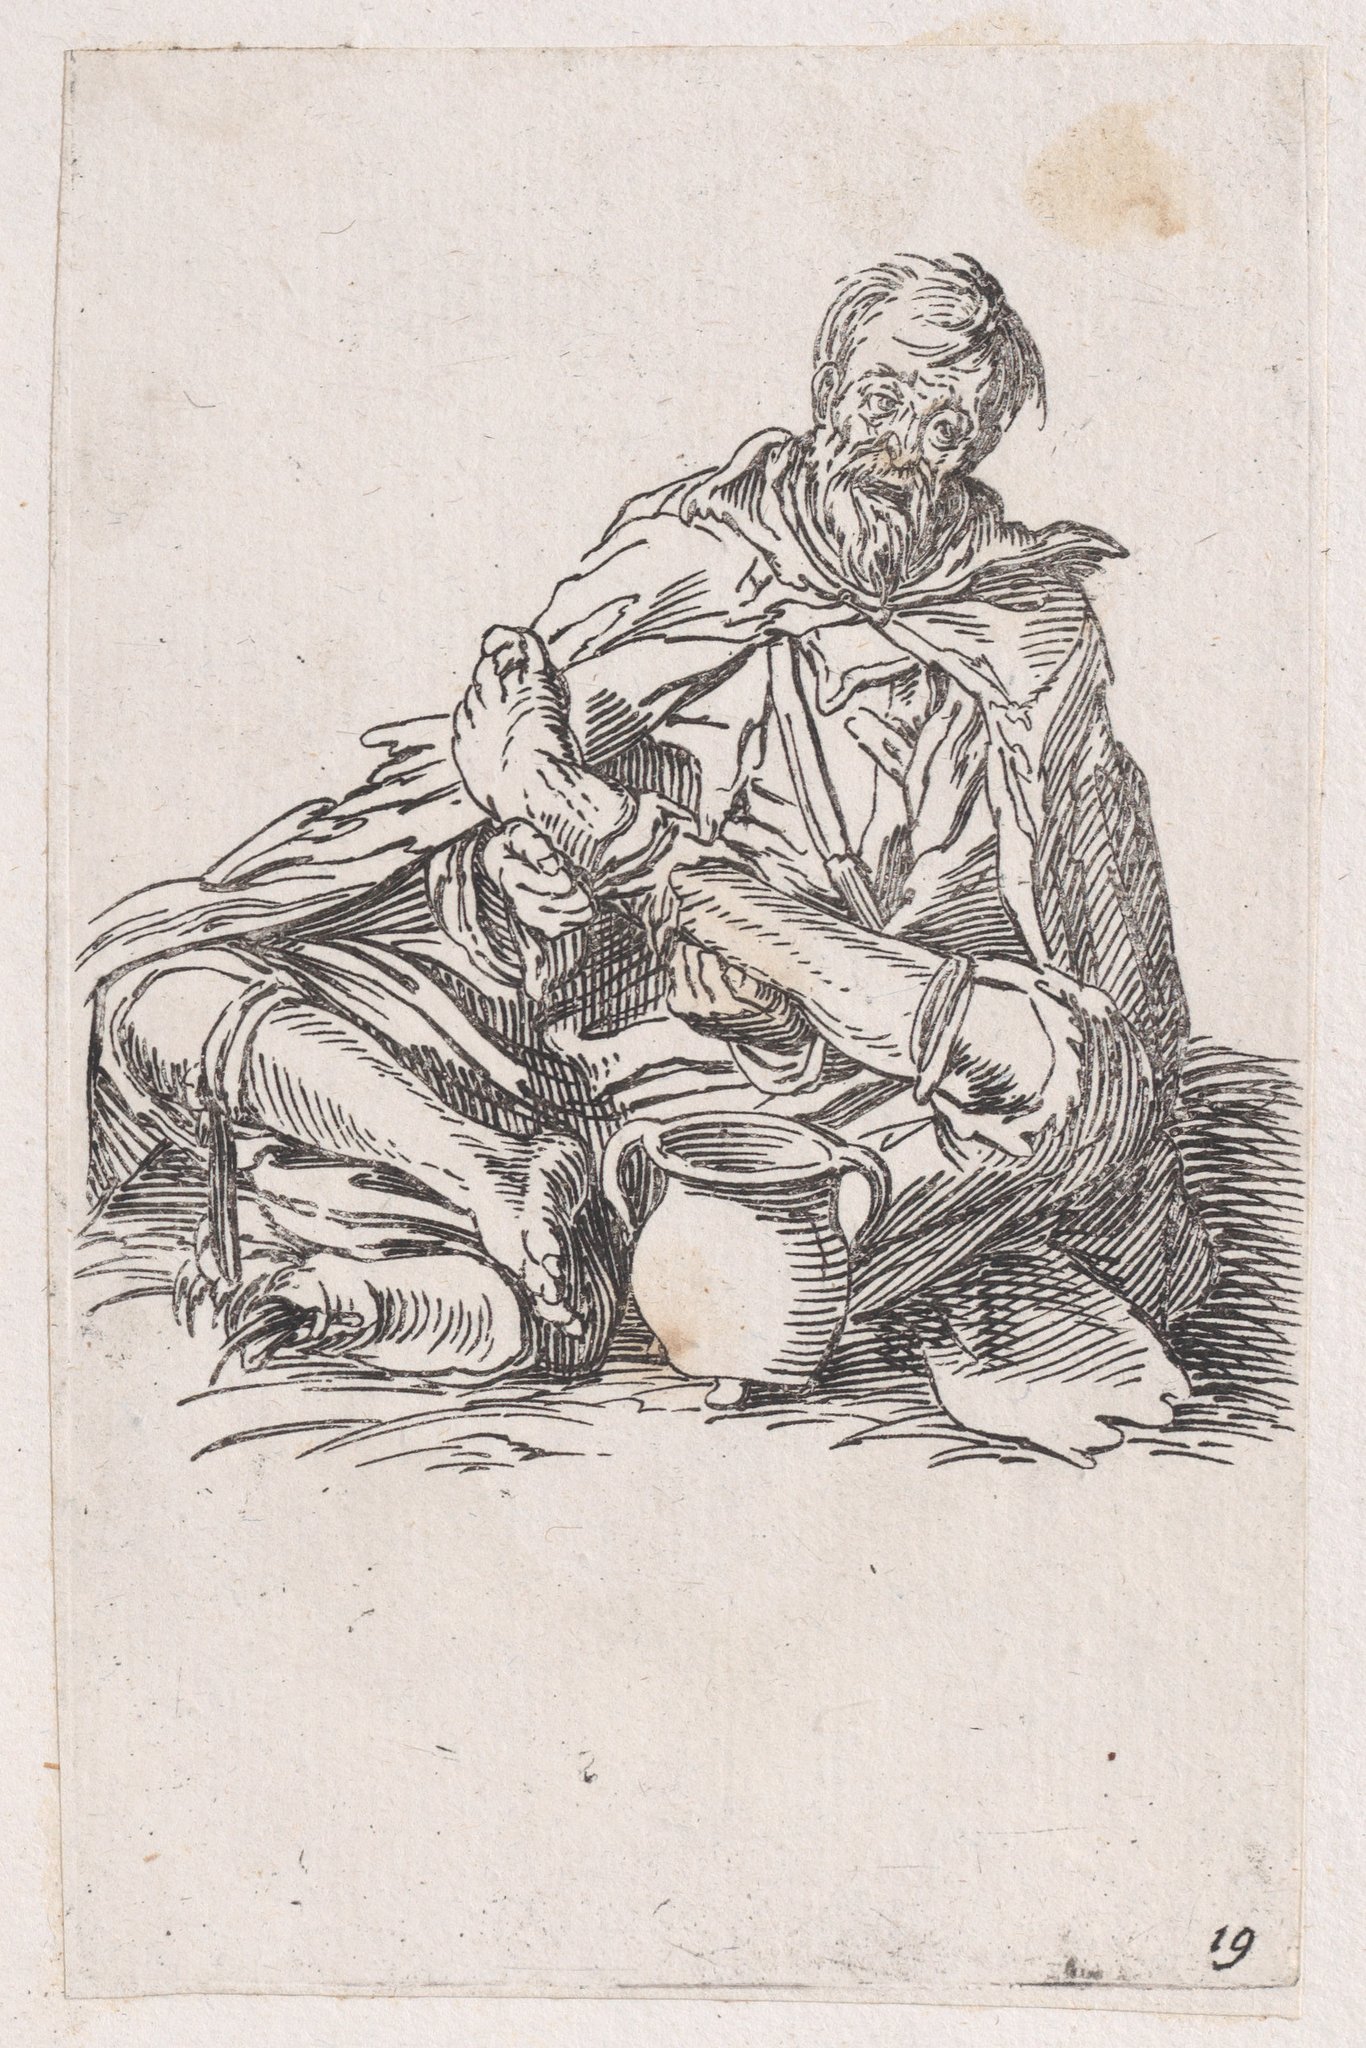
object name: print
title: Reverse Copy of Le Malingreux (The Sickly Man), from Les Gueux suite appelée aussi Les Mendiants, Les Baroni, ou Les Barons (The Beggars, also called the Barons)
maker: Anonymous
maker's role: artist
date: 1601-1700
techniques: etching